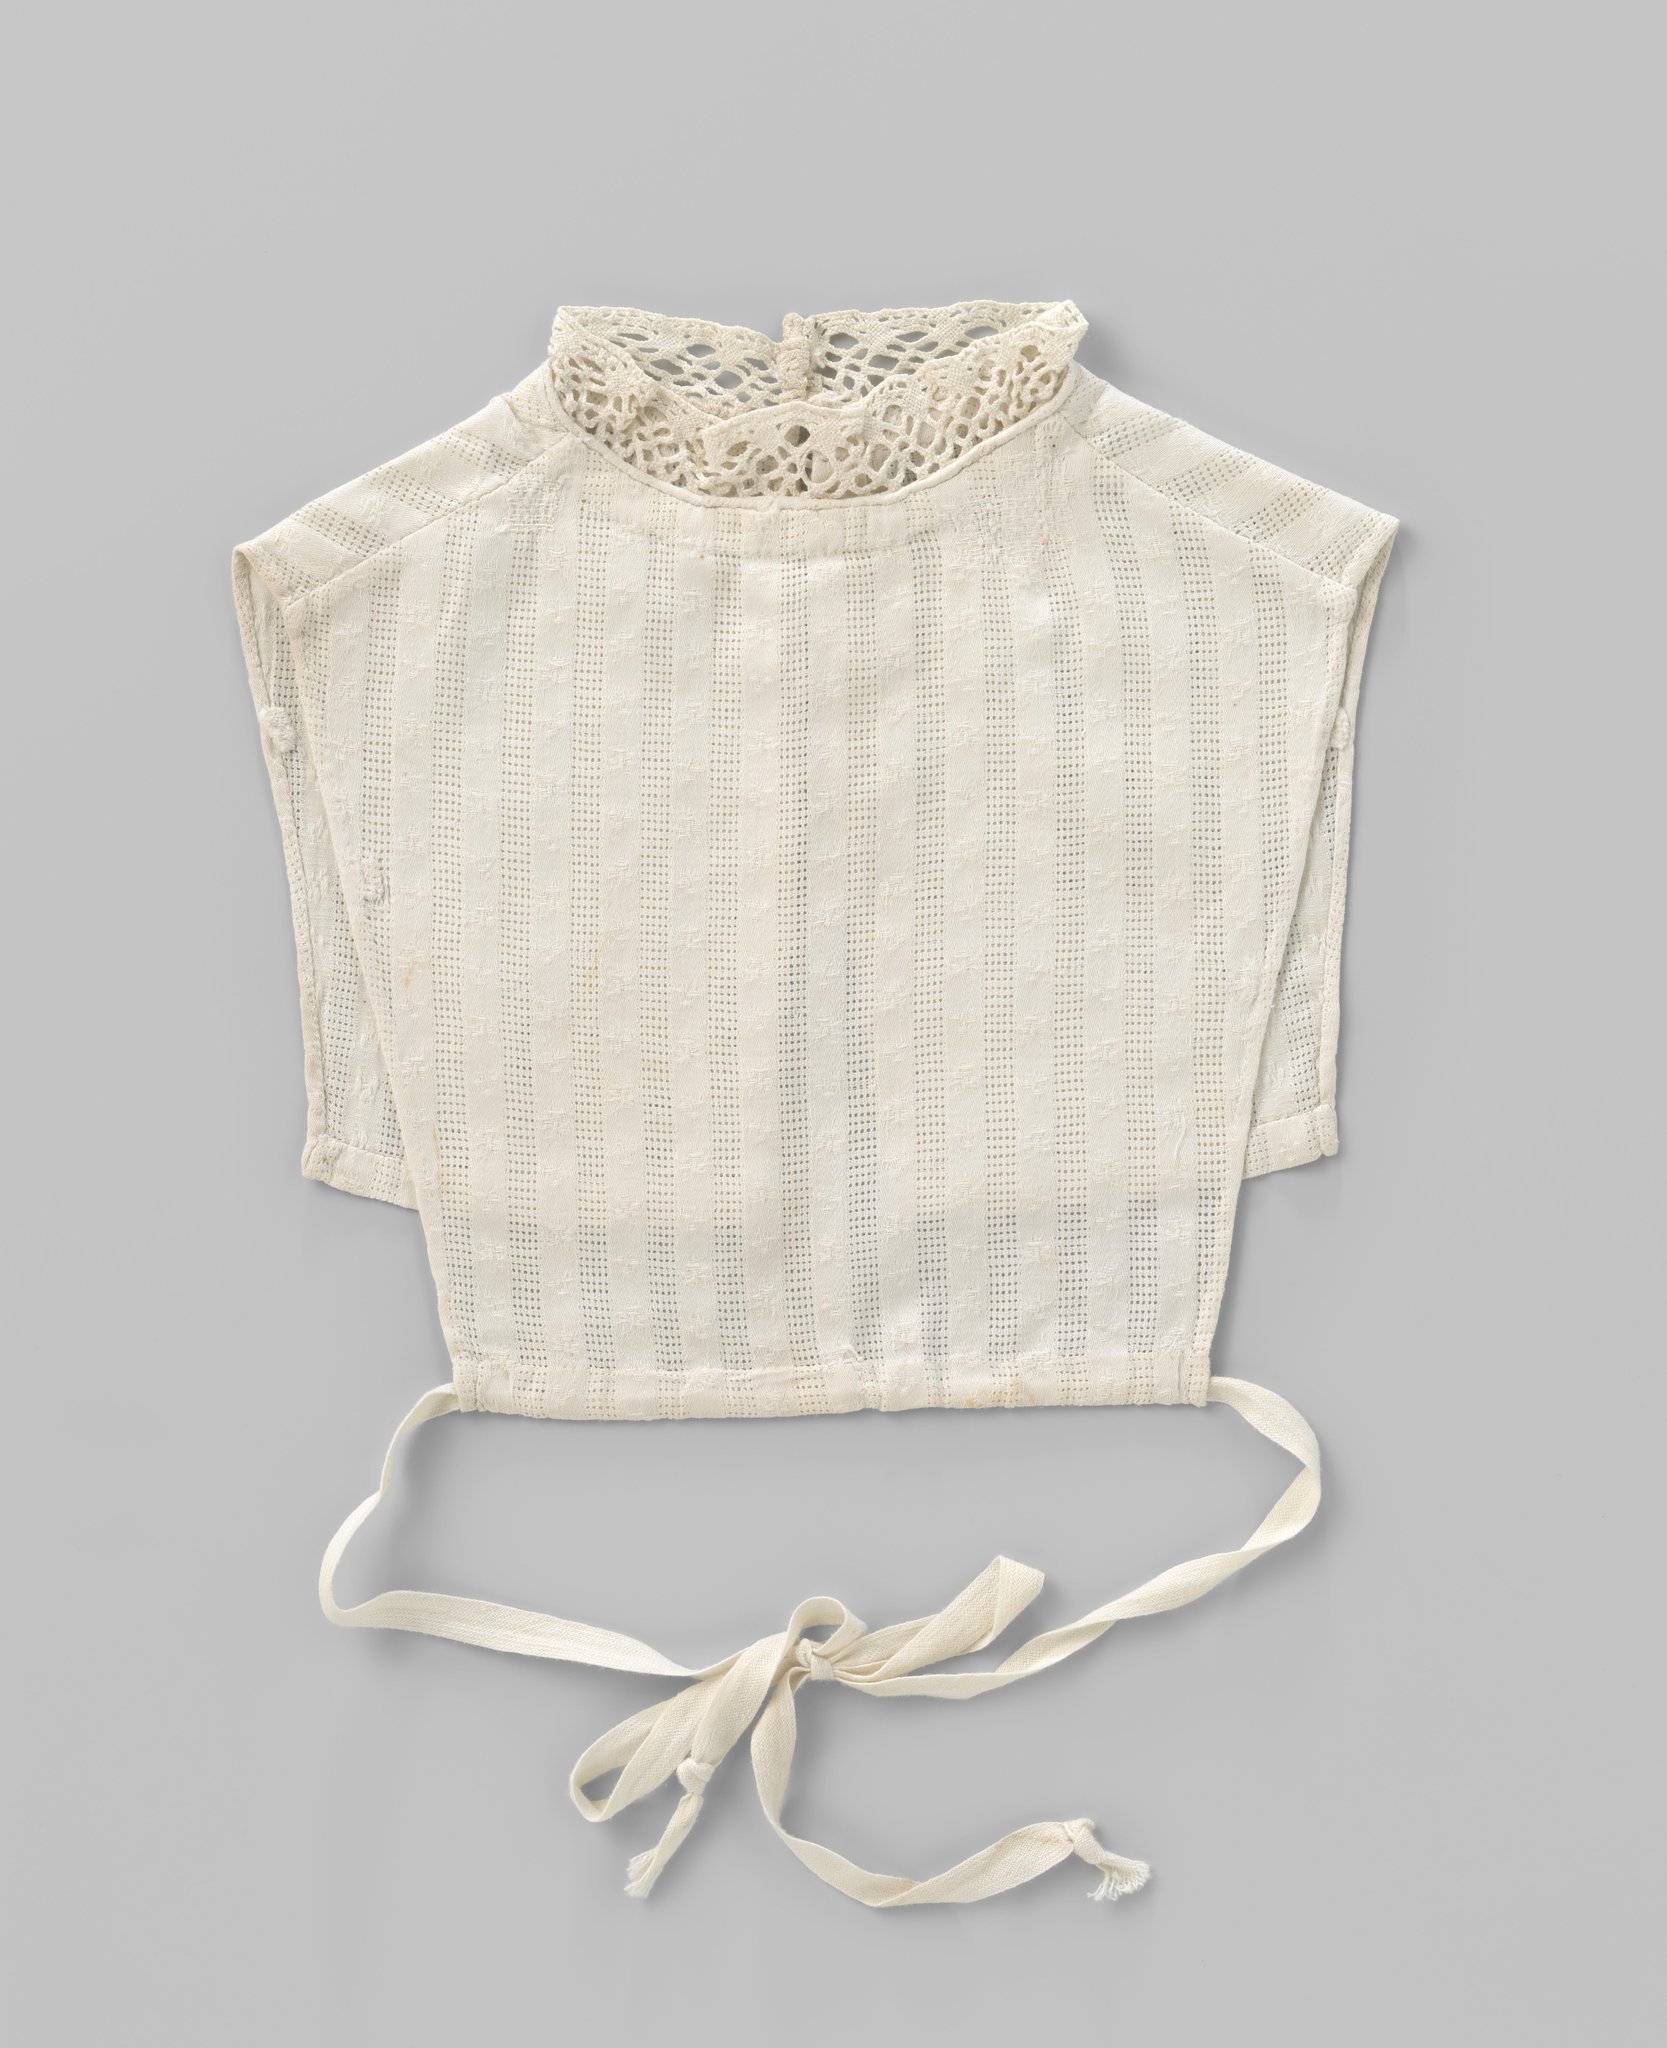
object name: baby wear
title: Lijfje met hals van ajourwerk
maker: Anonymous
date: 1800-1899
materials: cotton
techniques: embroidery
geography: netherlands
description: Aan de onderzijde van de voorzijde is een wit lint geregen.